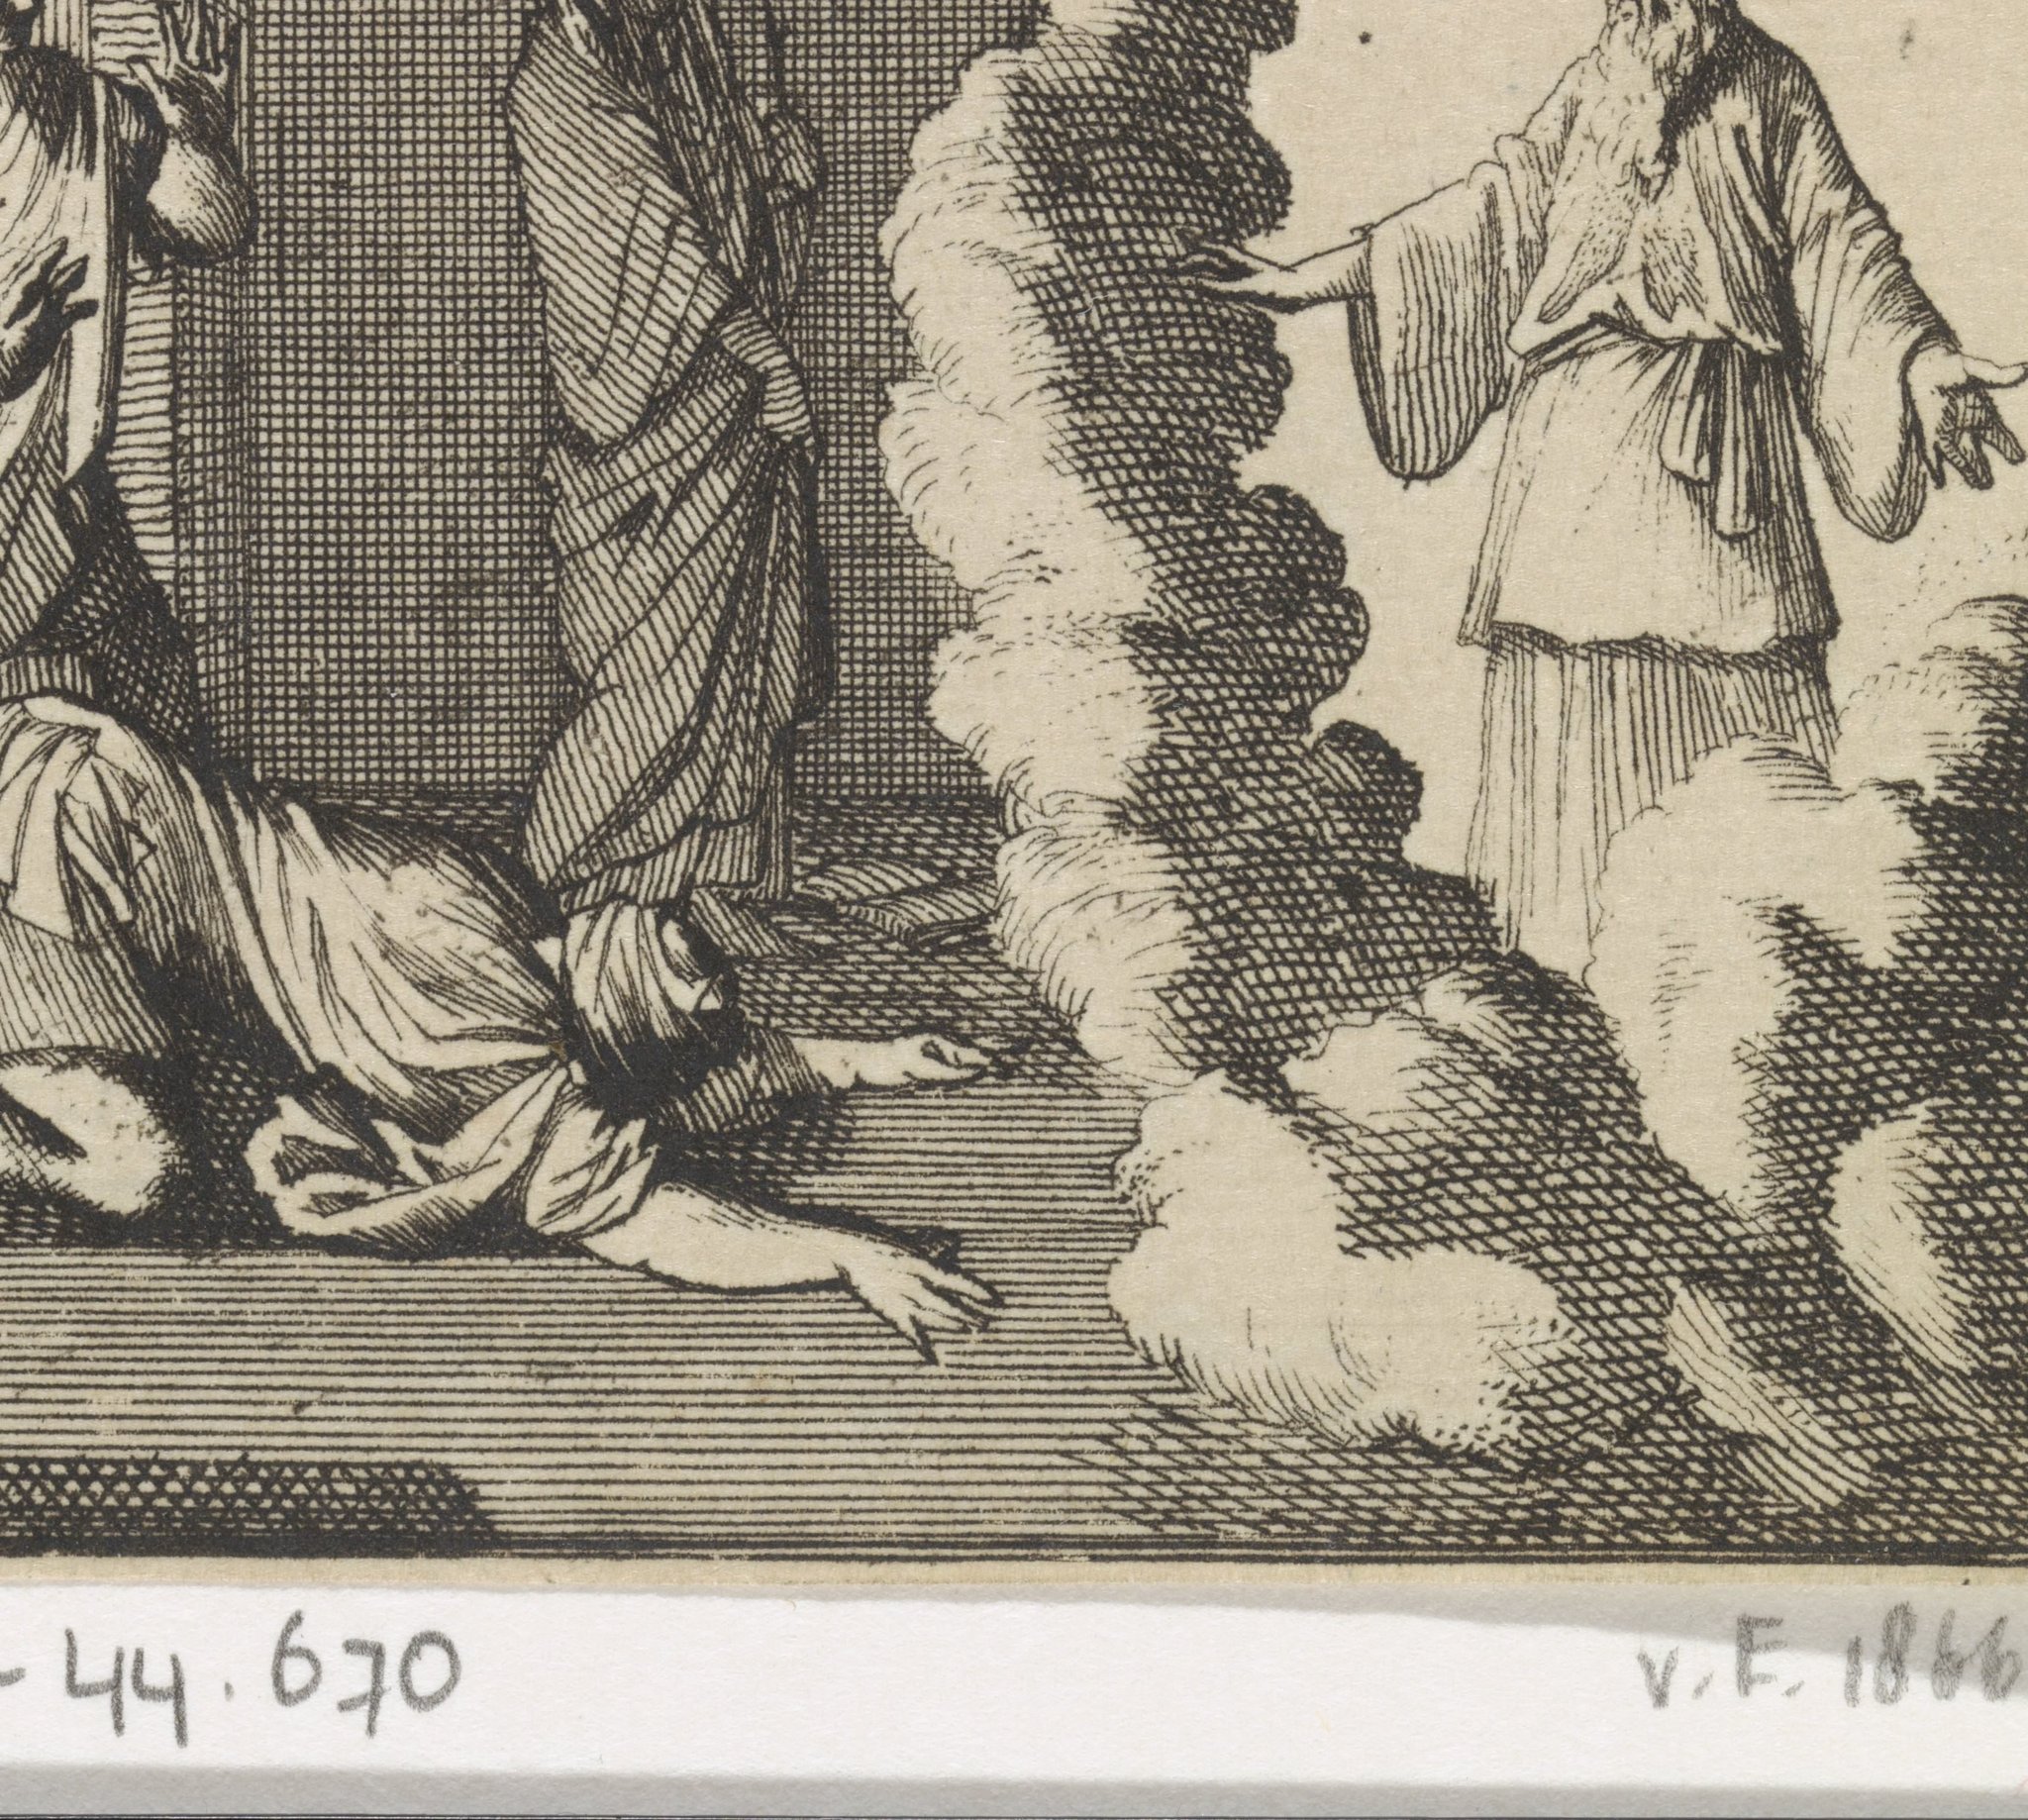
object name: print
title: Samuel verschijnt aan Saul bij de heks van Endor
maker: caspar luyken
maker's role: draughtsman, print maker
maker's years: 1672-1708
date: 1698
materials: paper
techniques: etching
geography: amsterdam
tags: saul and the witch of endor (1 samuel 28:3-25)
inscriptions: collector's mark: Lugt 2228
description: Proefdruk van illustratie uit: Josephus, Flavius. XX. boeken van de oude geschiedenissen der joden, 4 delen. Amsterdam: Barent Visscher, Willem de Coup, Willem van Lamsveld, Andries van Damme, 1698, dl. I.